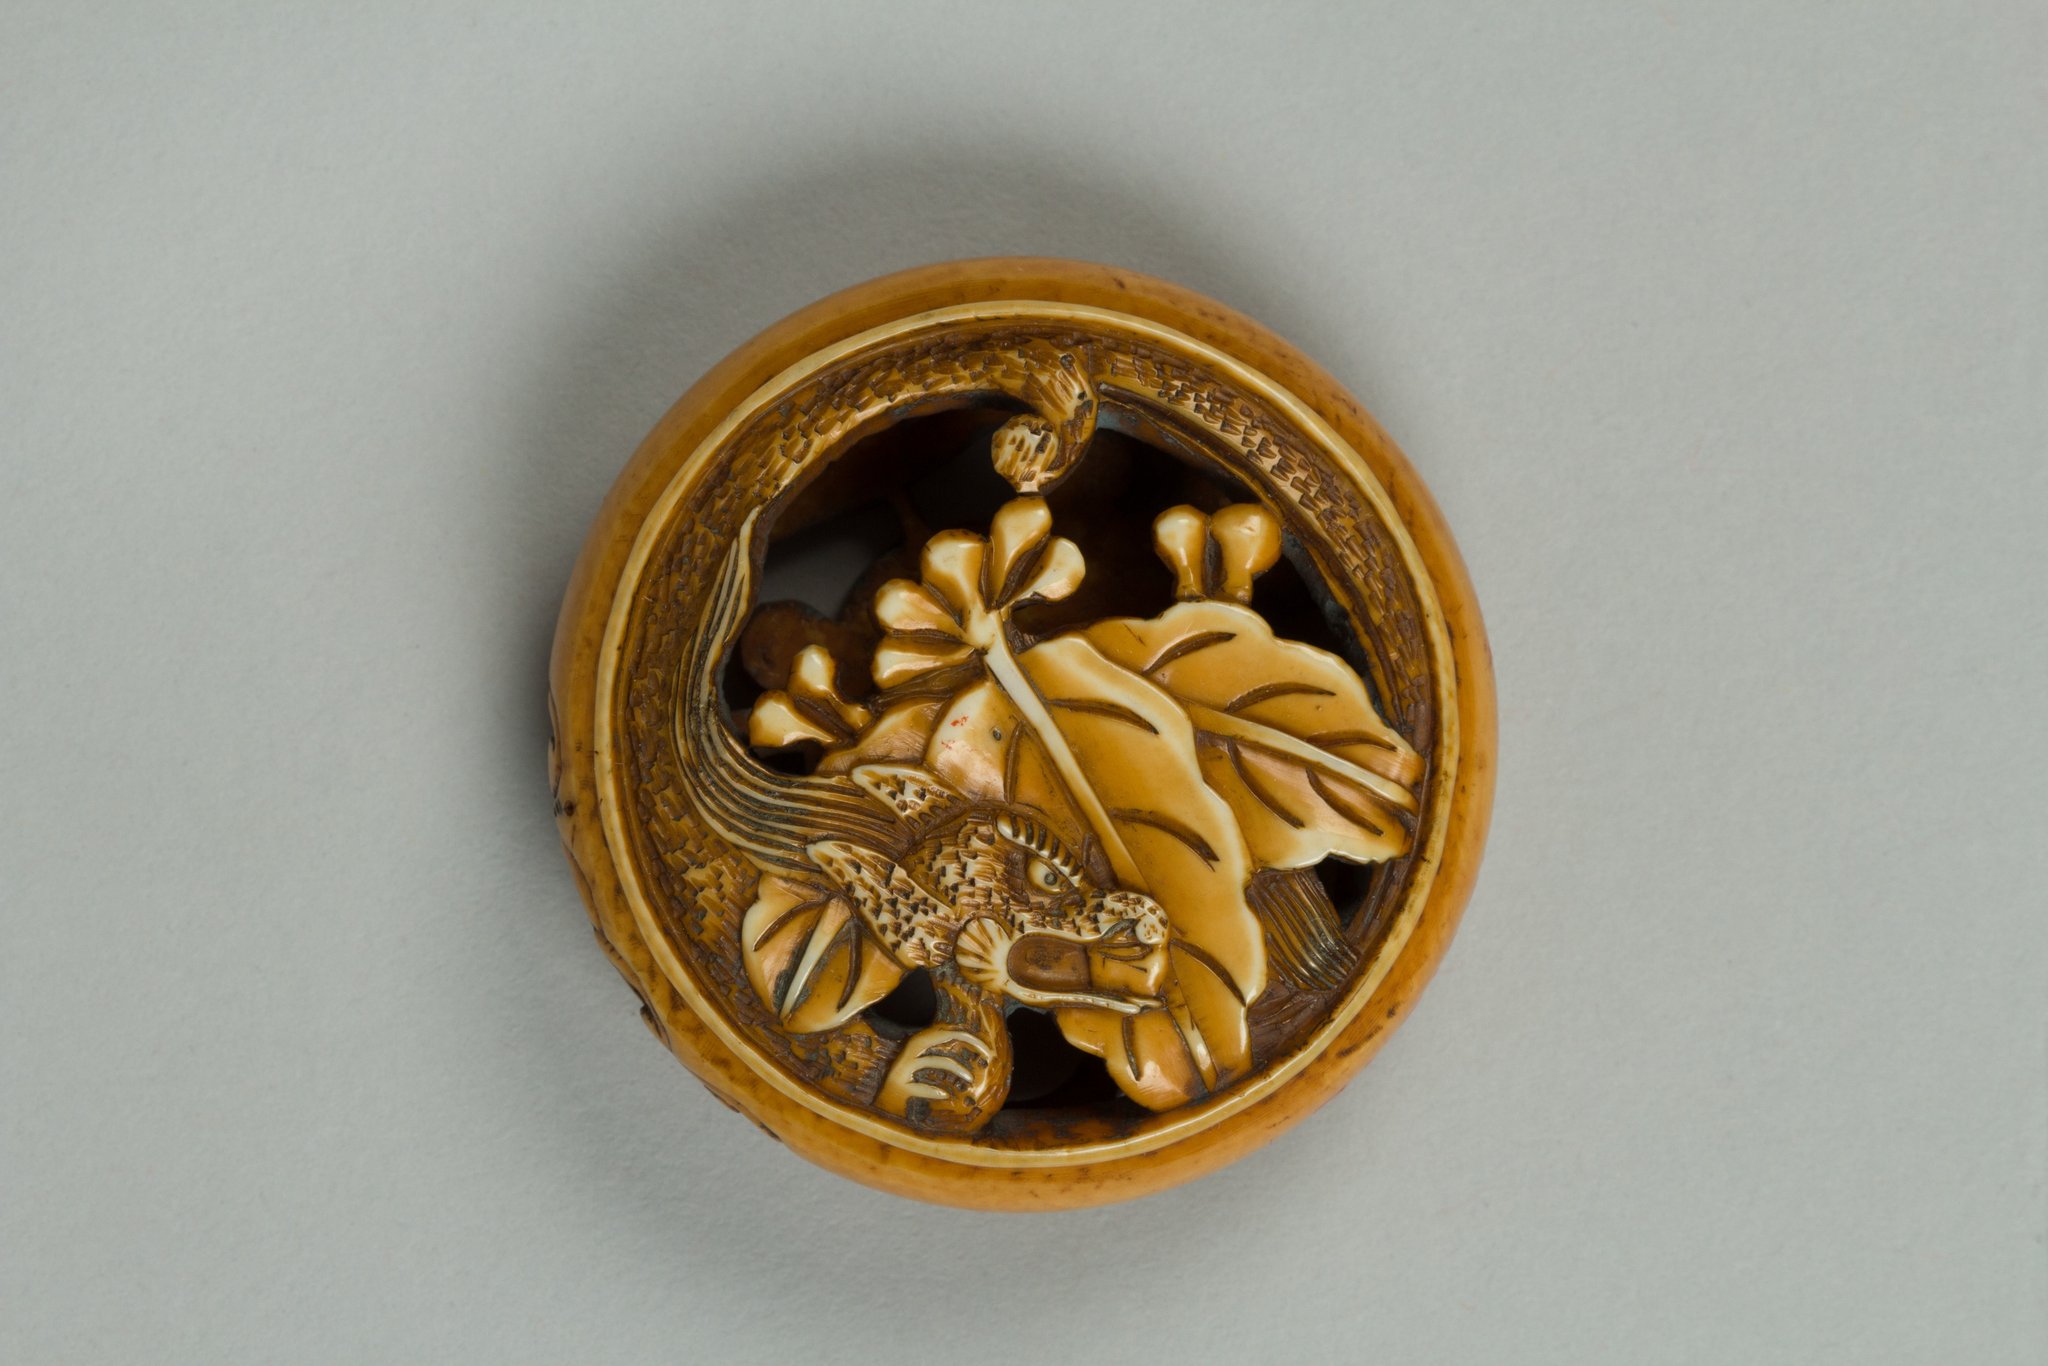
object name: netsuke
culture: japanese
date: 1801-1900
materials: ivory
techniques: stain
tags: dragons